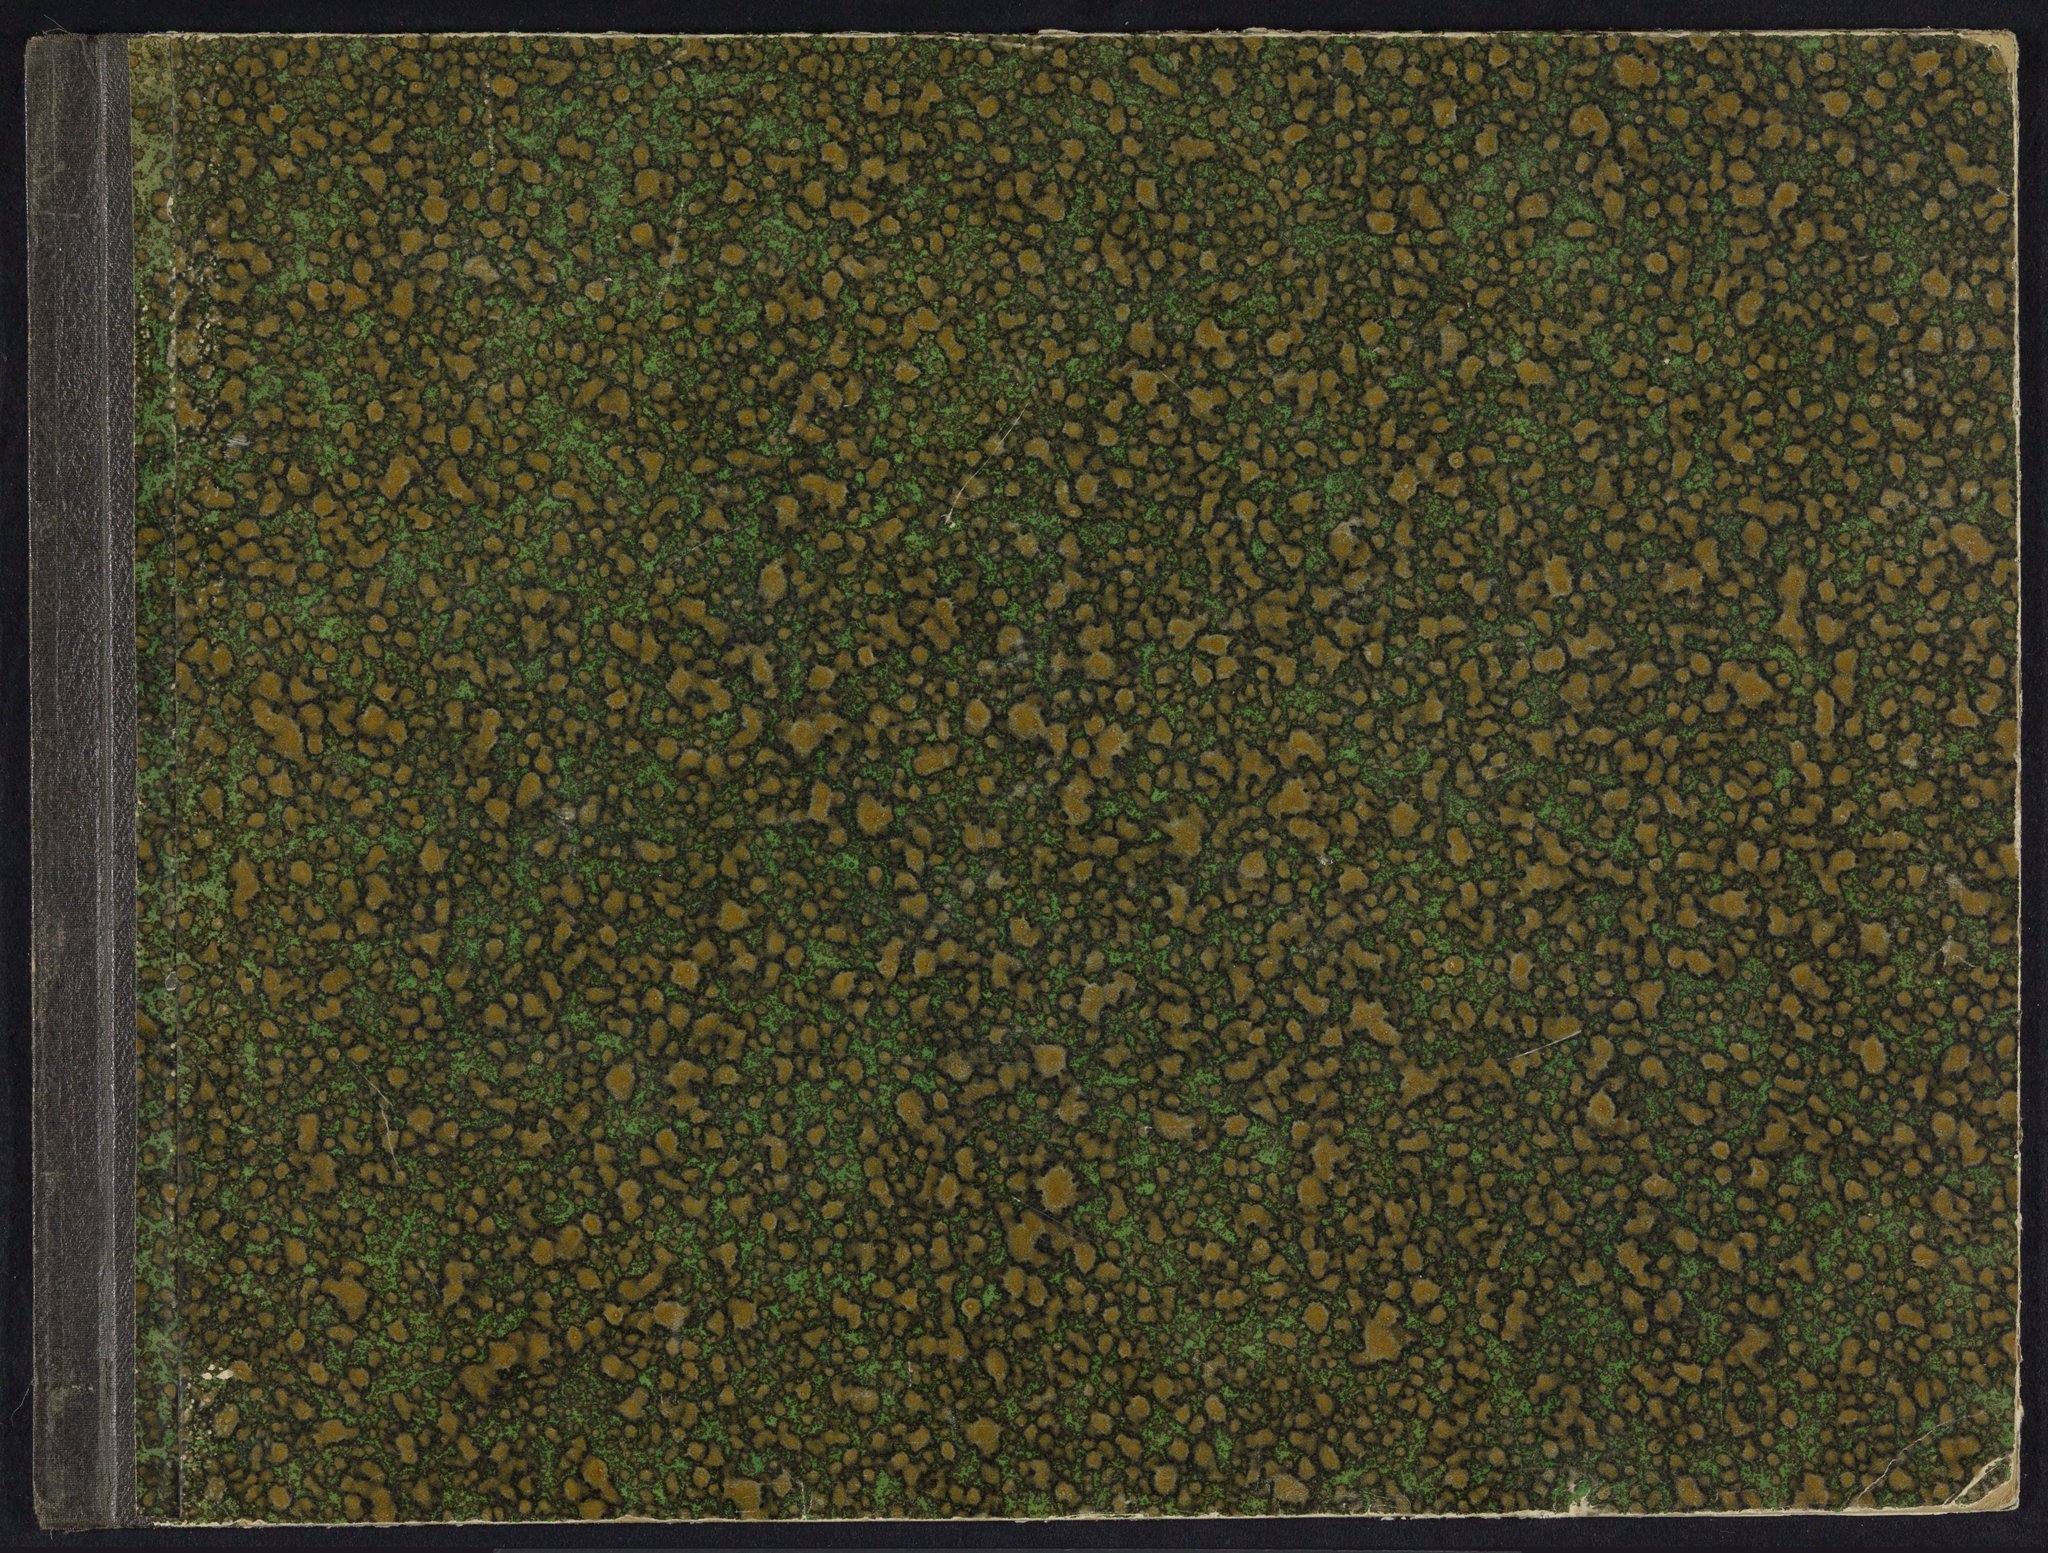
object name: writing book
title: Album met schrijfvoorbeelden van Ambrosius Perling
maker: ambrosius perling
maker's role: print maker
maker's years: 1657-1718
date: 1667-1718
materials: leather, linen, paper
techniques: bookbinding, engraving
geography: amsterdam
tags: calligraphy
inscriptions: collector's mark: Lugt 2166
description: Album met vijf voorstellingen op vijf albumbladen. Het gaat om schrijfvoorbeelden geschreven en gegraveerd door Ambrosius Perling. Halflinnen band met gemarmerde platten.